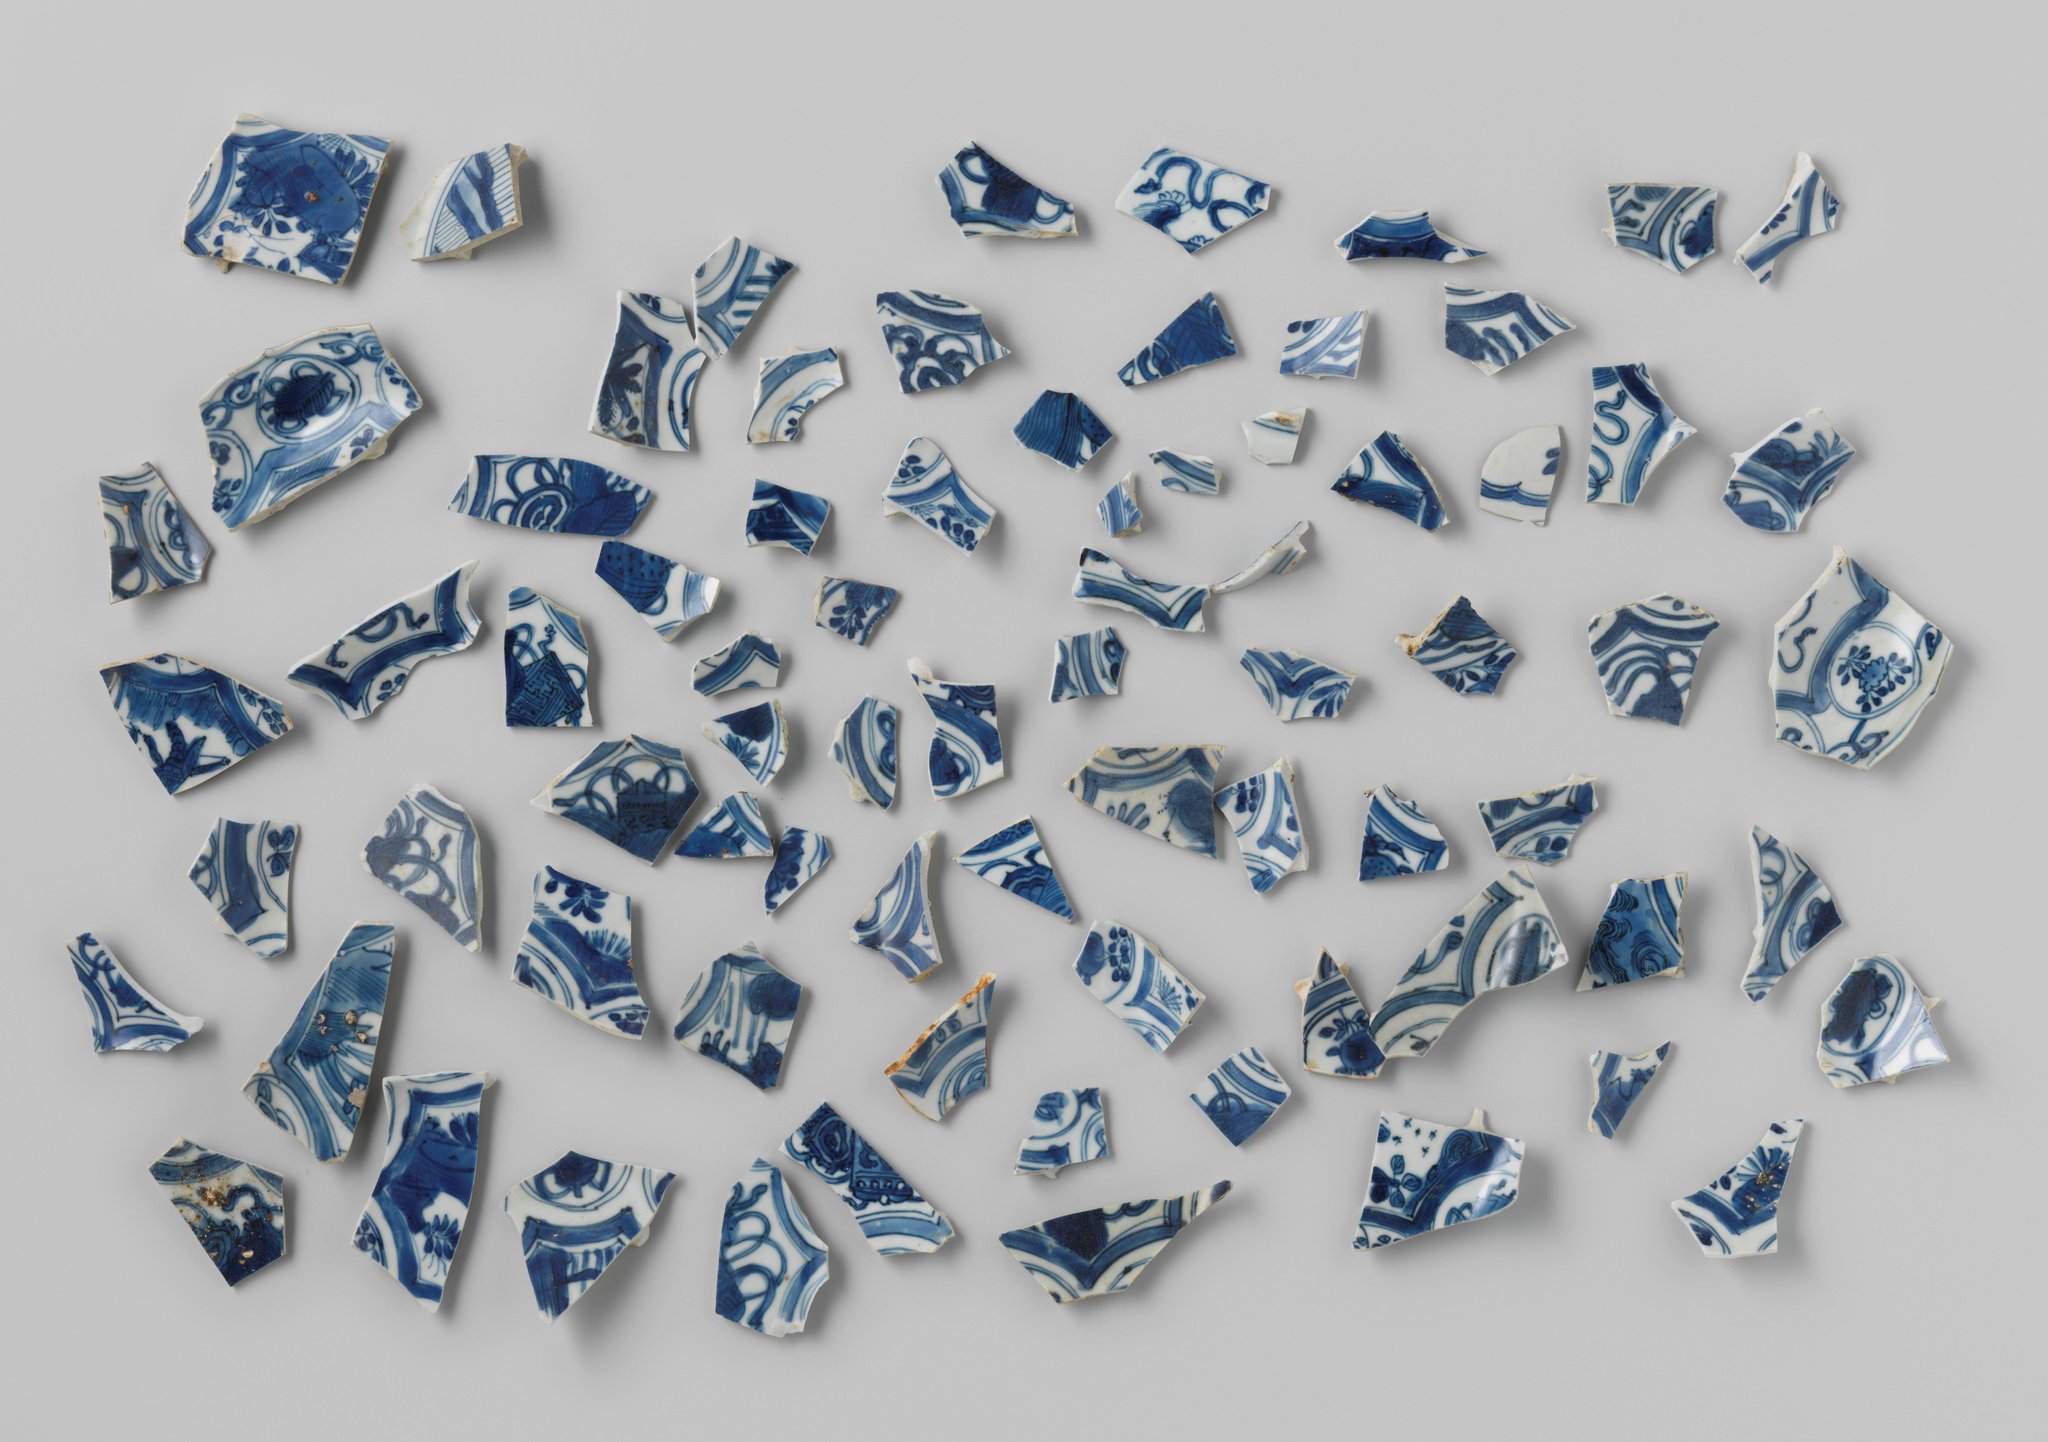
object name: plate dish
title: Scherven van borden uit V.O.C.-schip de 'Witte Leeuw'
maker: Anonymous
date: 1613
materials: bone china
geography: jingdezhen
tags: verenigde oostindische compagnie, sint-helena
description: Scherven van borden uit V.O.C.-schip de 'Witte Leeuw'.